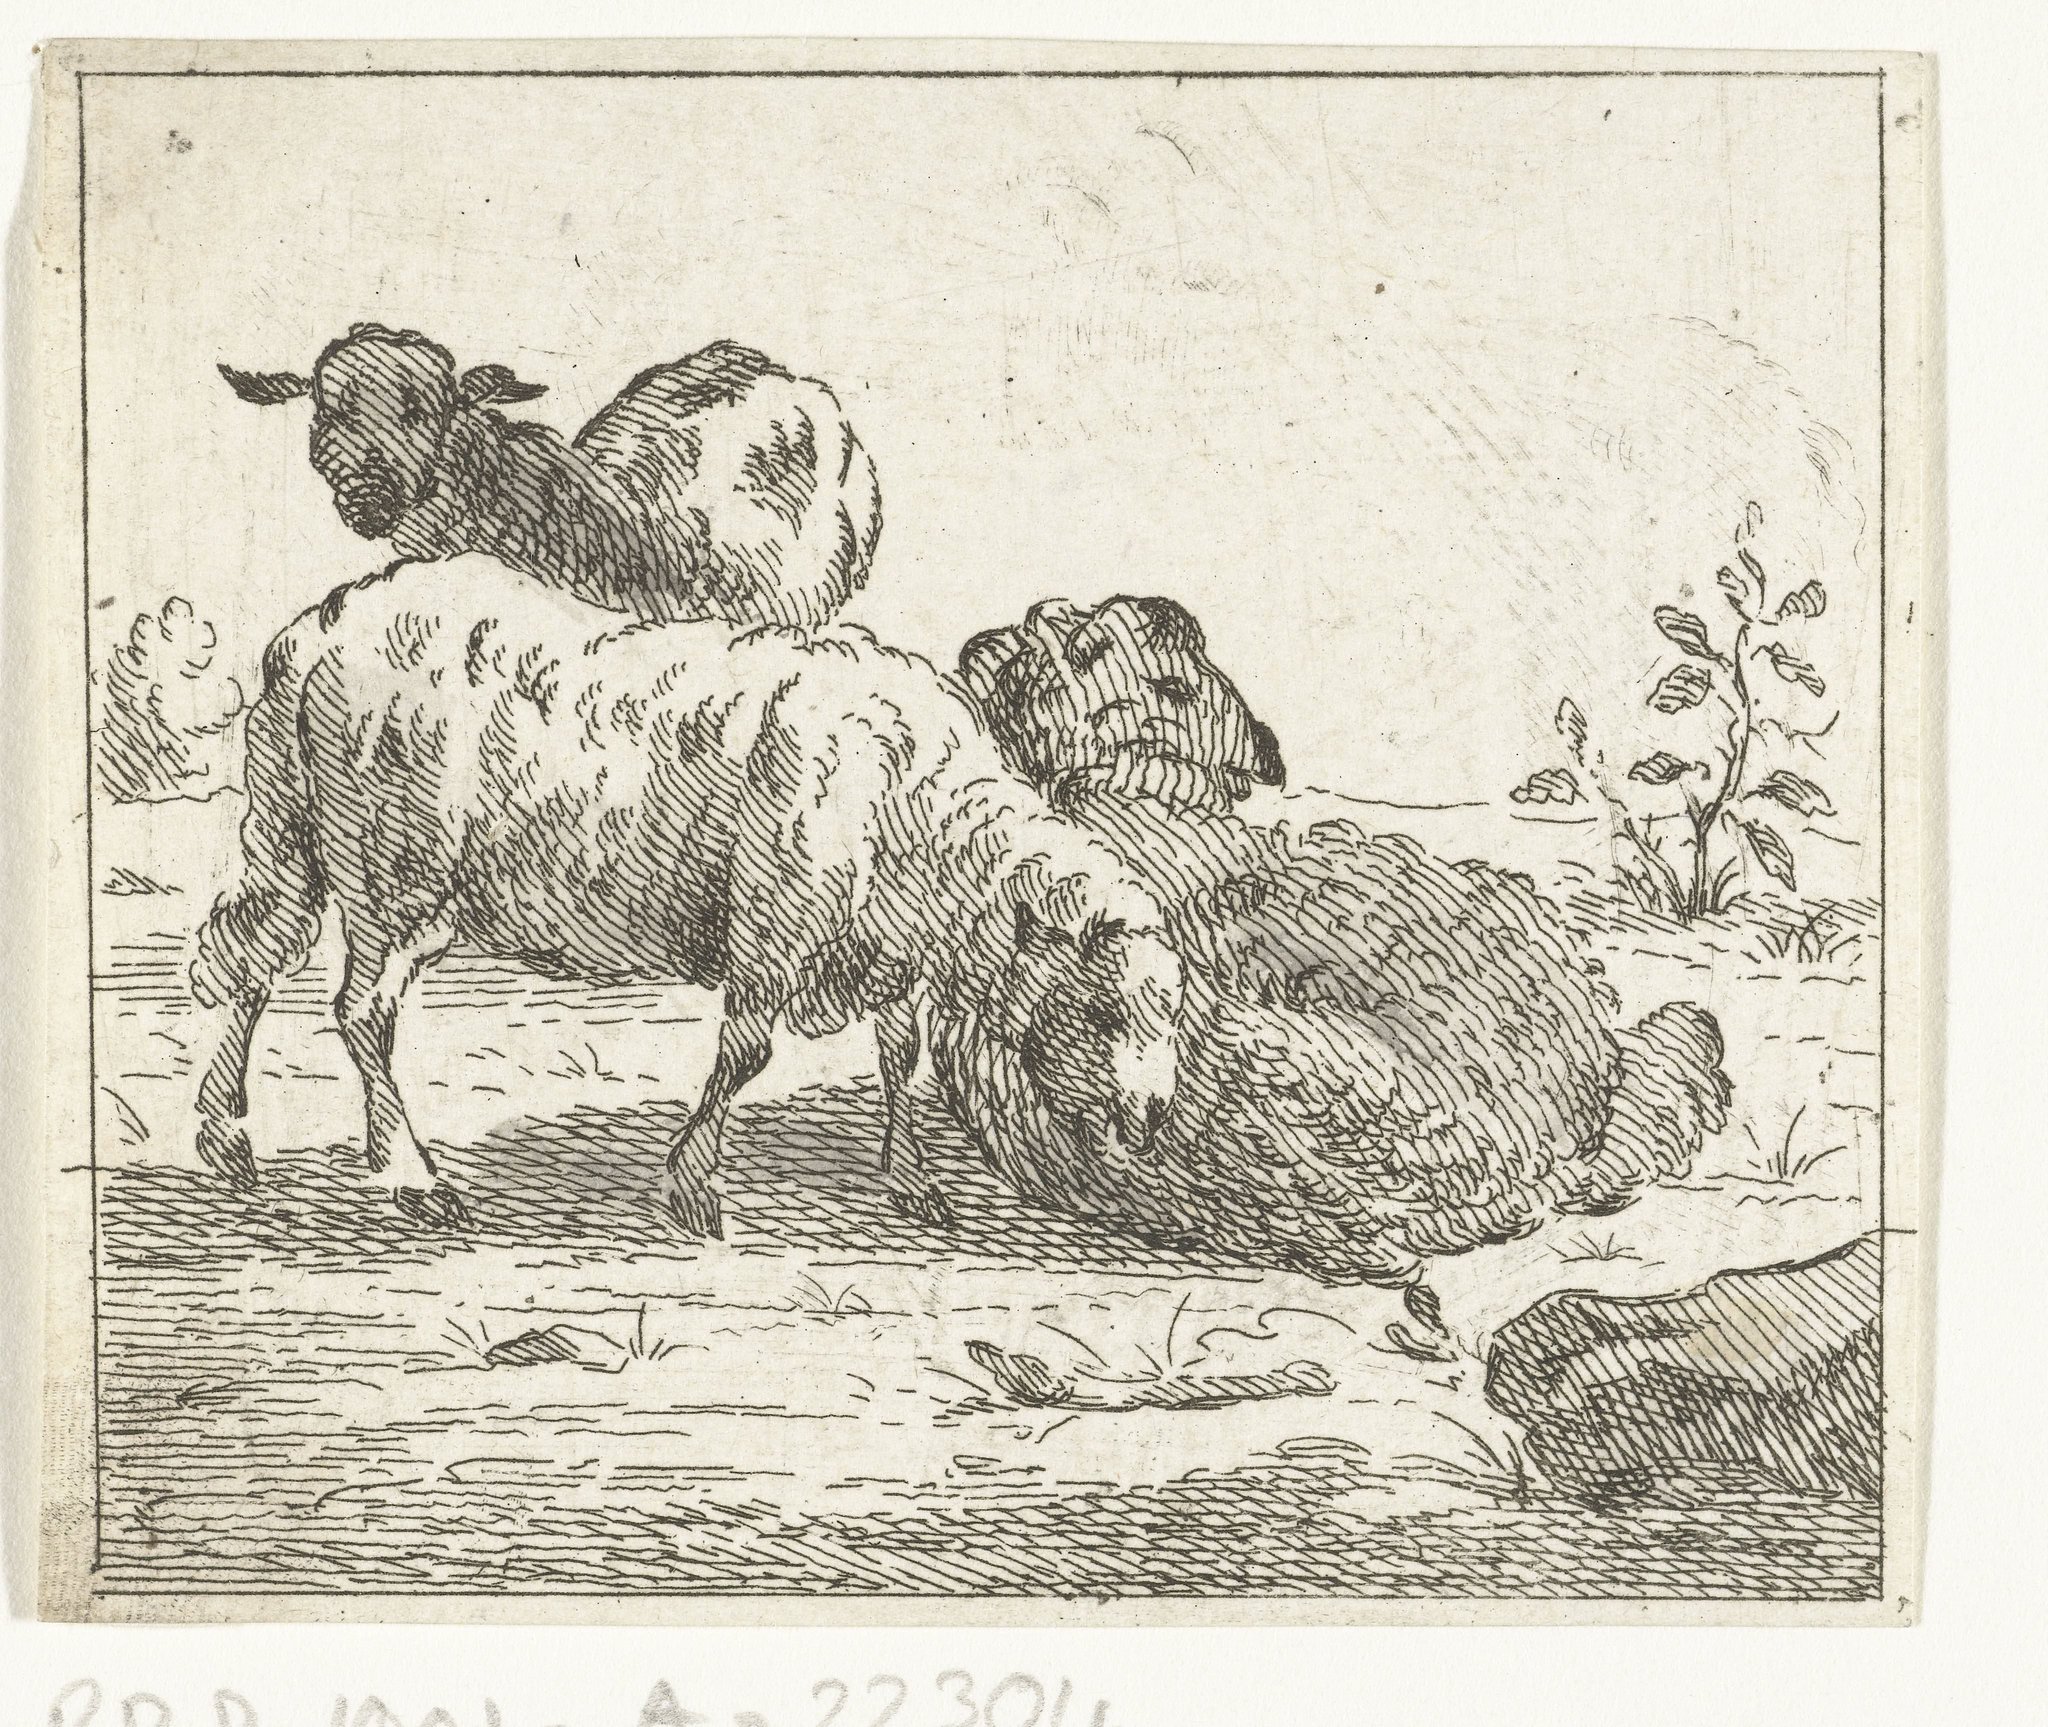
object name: print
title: Drie schapen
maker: jan matthias cok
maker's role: draughtsman, print maker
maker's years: 1720-1771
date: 1735-1771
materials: paper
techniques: etching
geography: amsterdam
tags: sheep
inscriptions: number: ‘7’, collector's mark: Lugt 2228